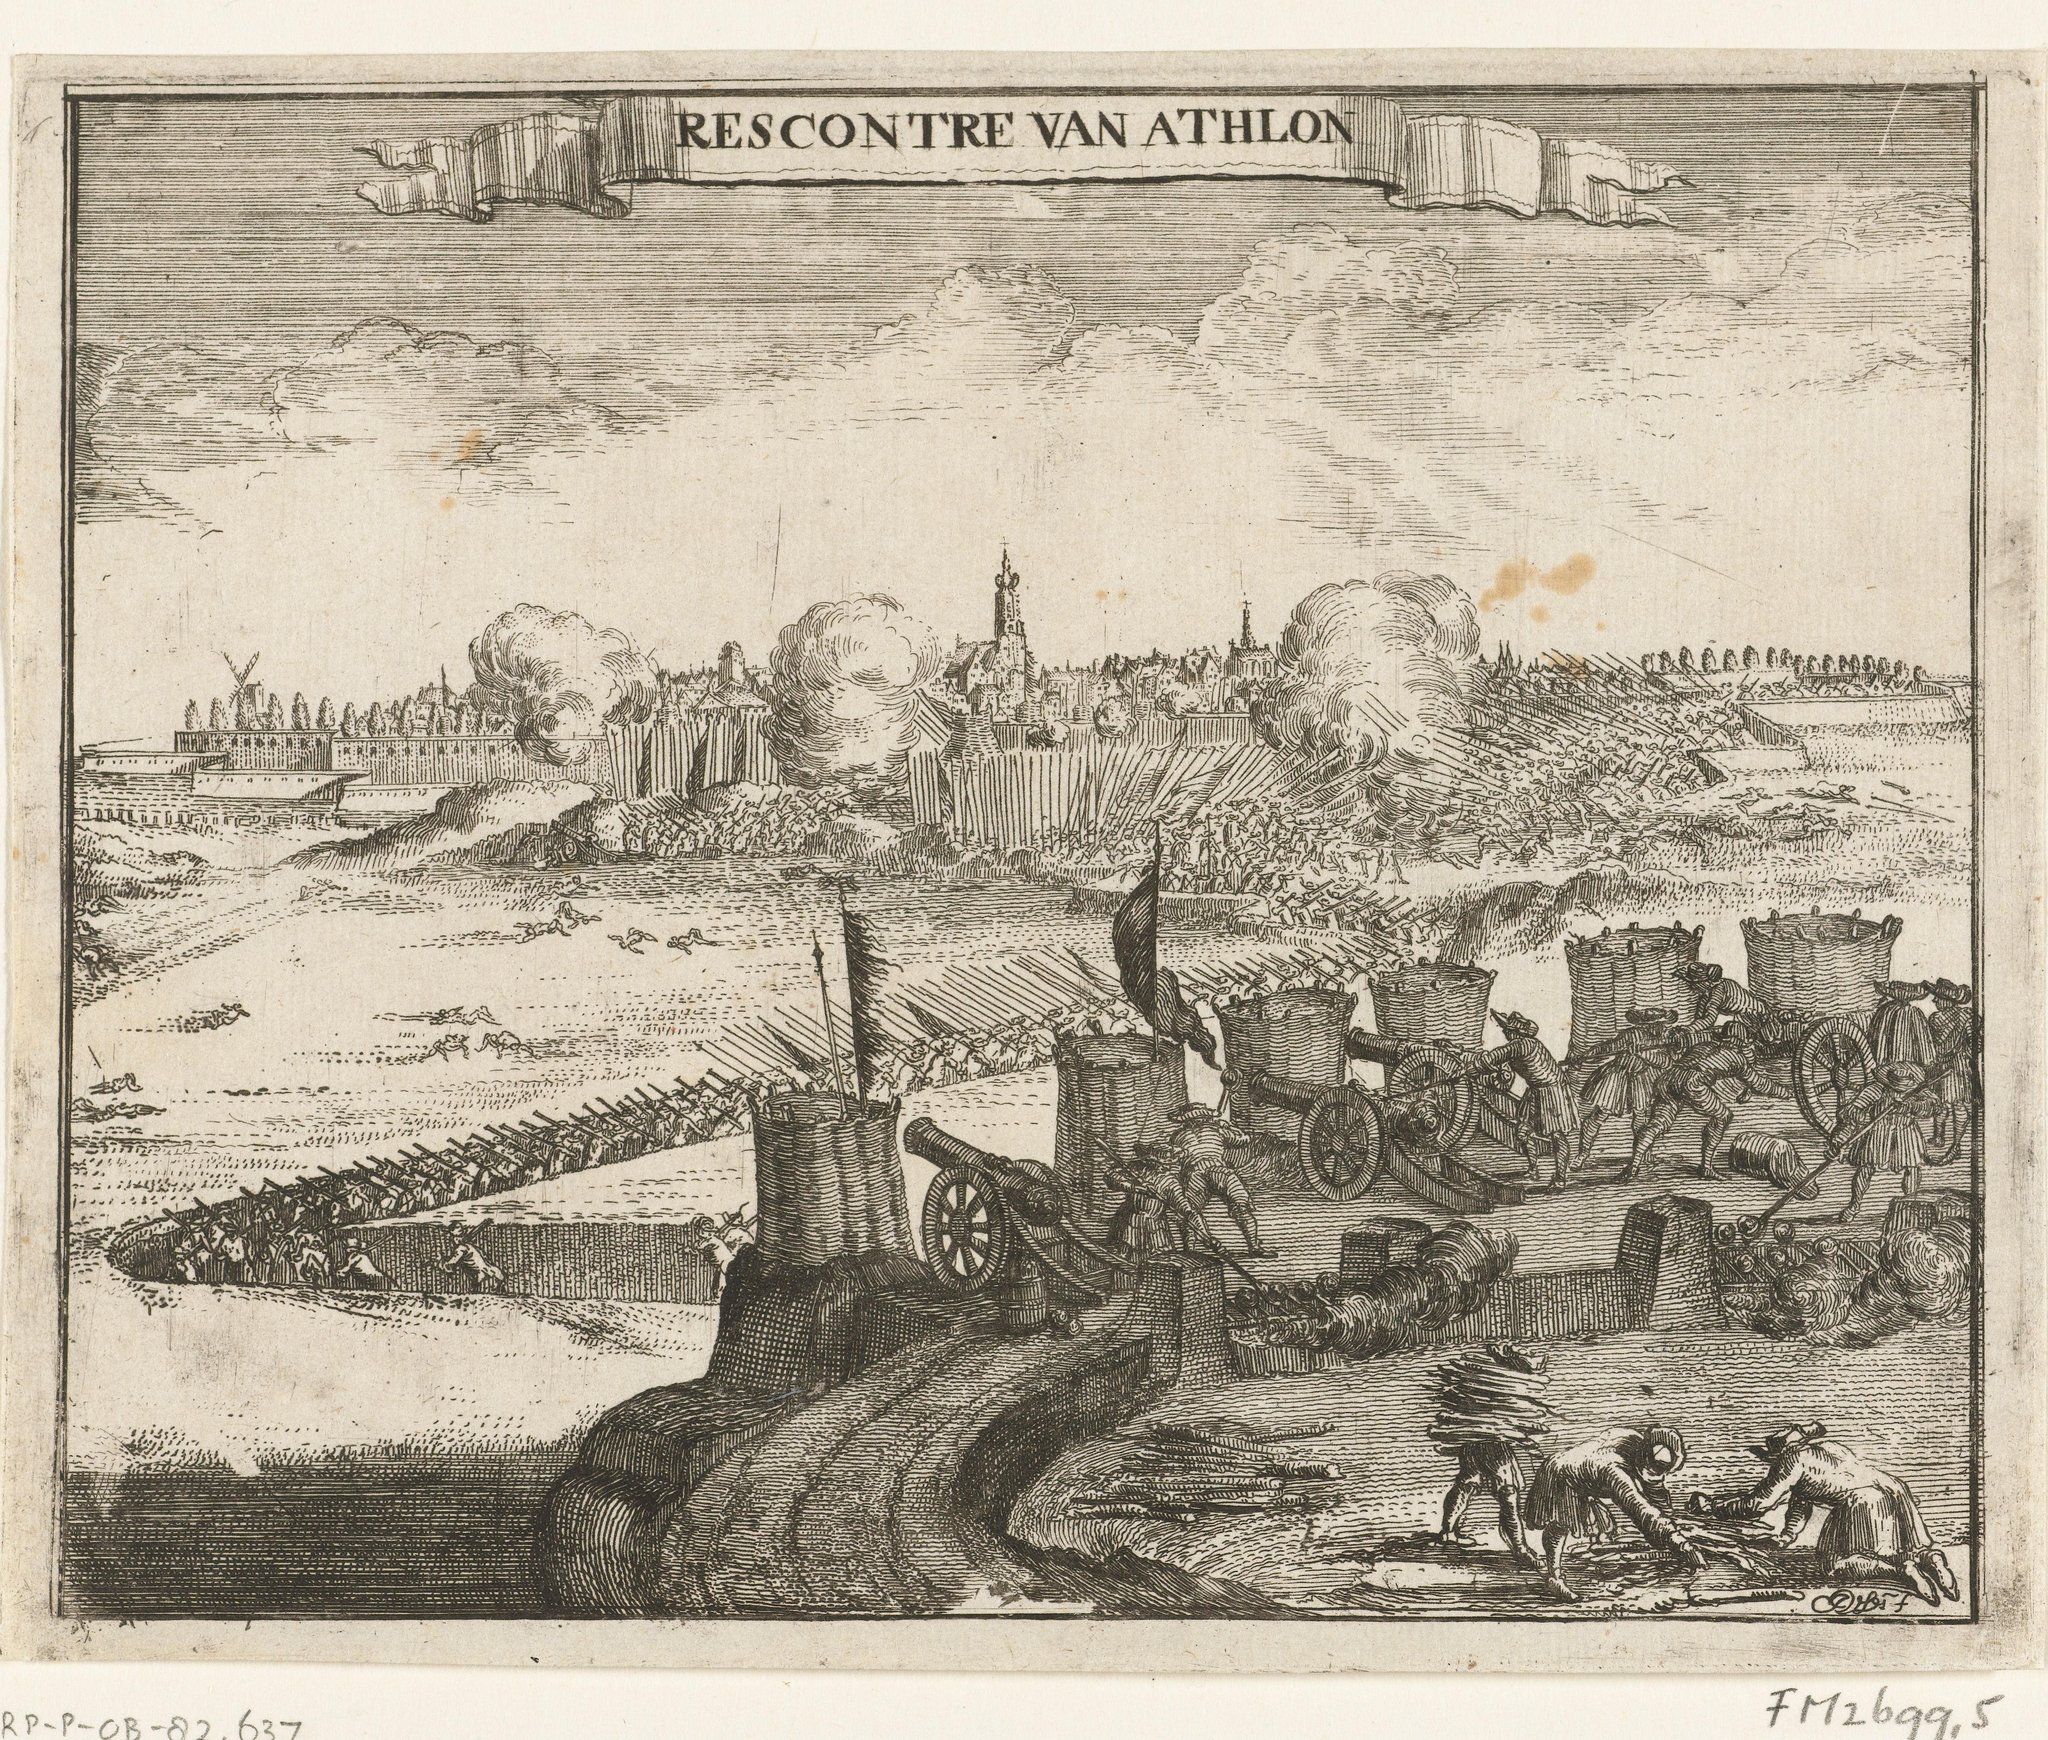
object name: print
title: Overwinningen van koning Willem III, 1690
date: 1690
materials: paper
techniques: etching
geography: northern netherlands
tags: the hague, william iii (prince of orange and king of england, scotland, and ireland), siege, position war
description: Beleg van Athlone in Ierland door Engelse troepen onder koning Willem III, 1690. Onderdeel van een serie van overwinningen van koning Willem III in 1690.